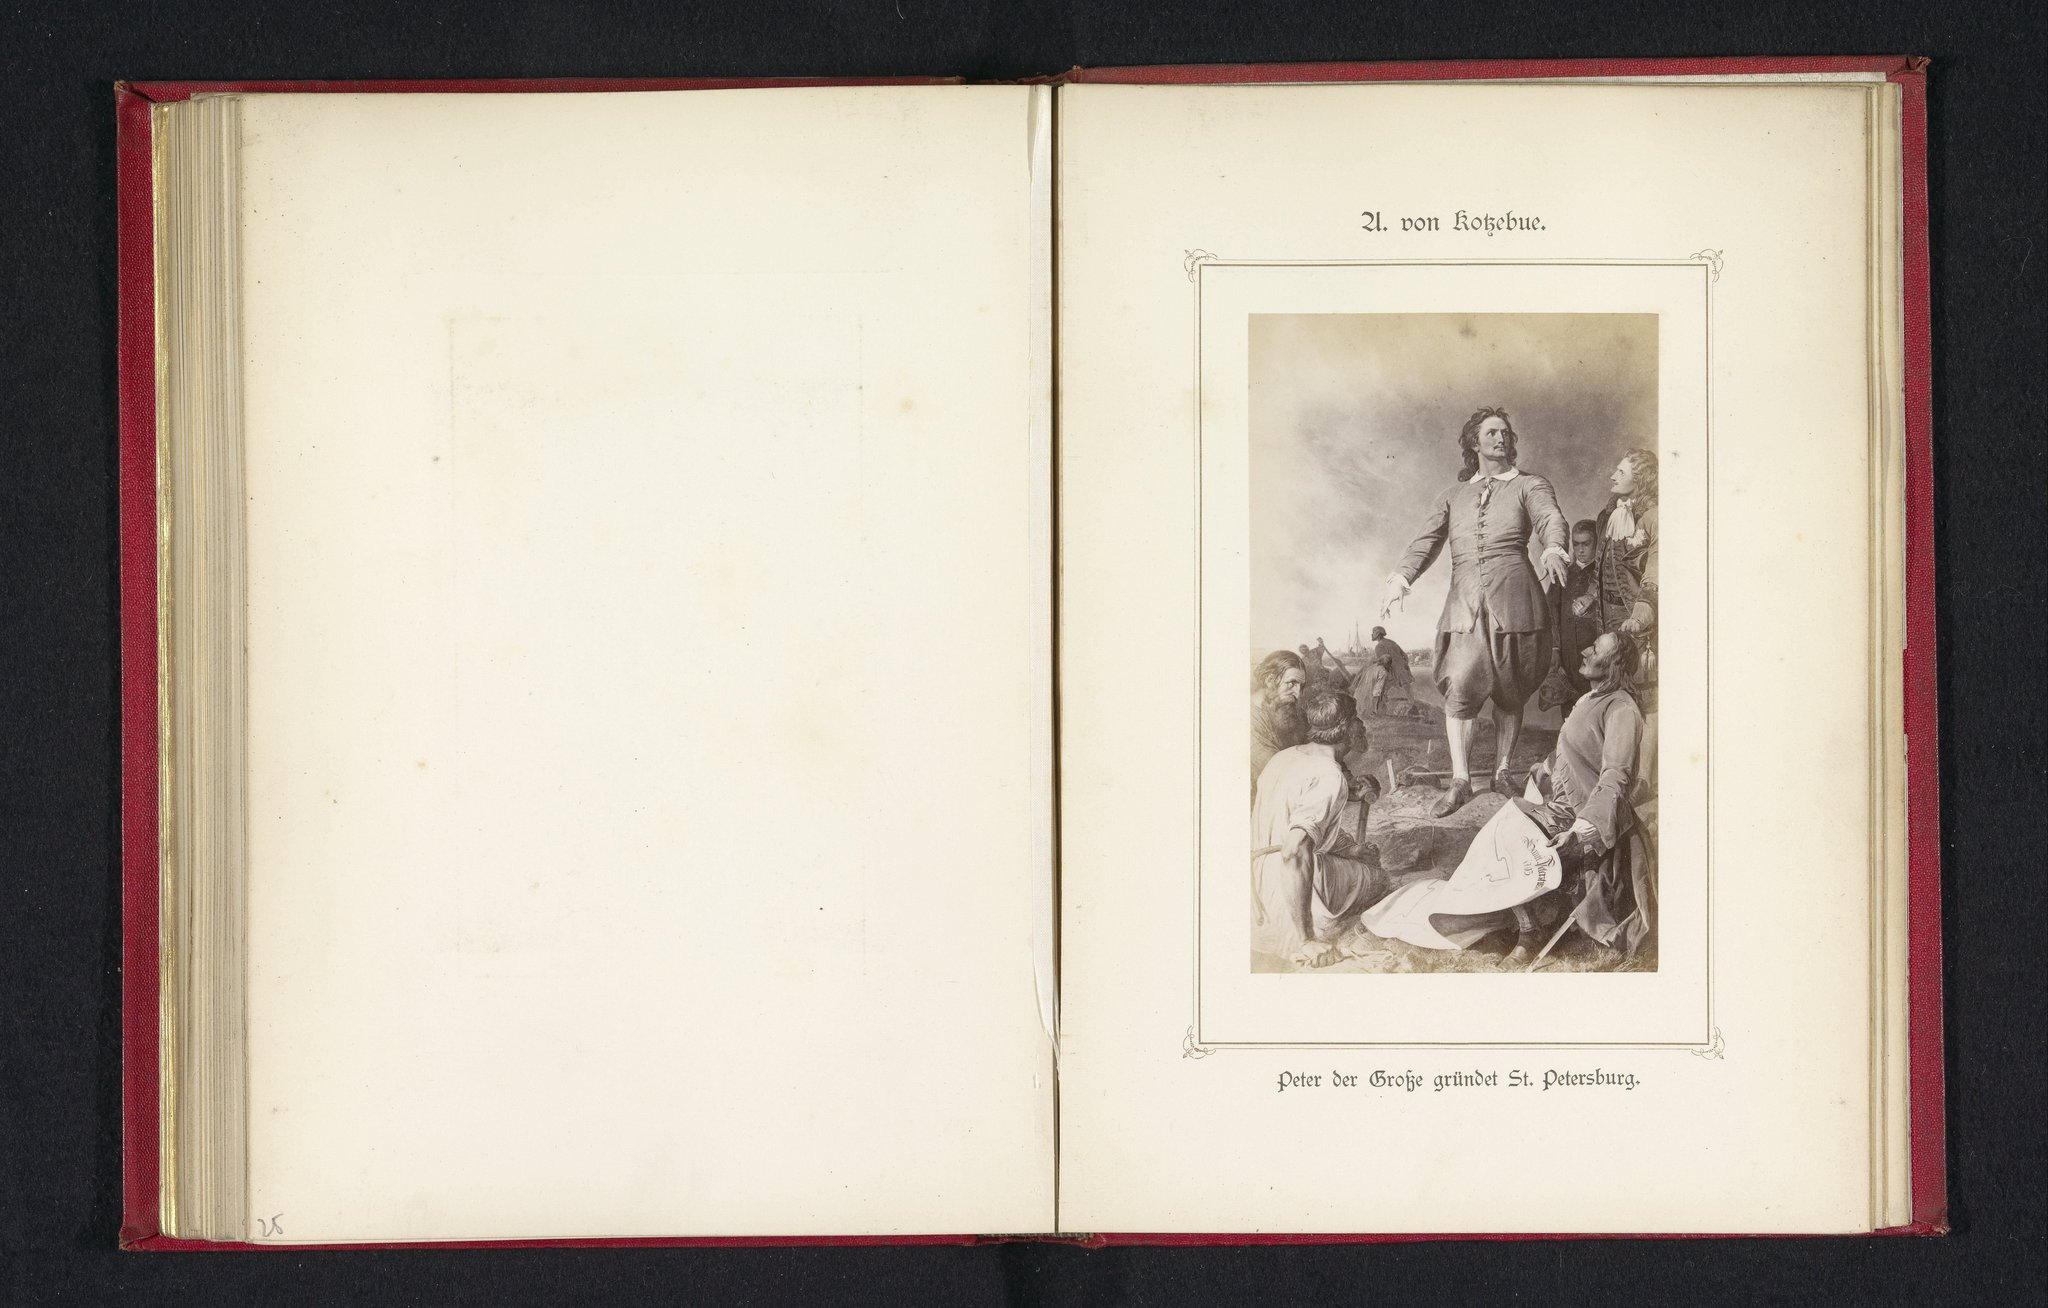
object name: reproduction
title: Fotoreproductie van een schilderij, voorstellende koning Lodewijk XIV van Frankrijk ontvangt gezanten uit Genua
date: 1875-1880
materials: photographic support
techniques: albumen print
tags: lodewijk xiv (koning van frankrijk), audition; ruler giving audience, king